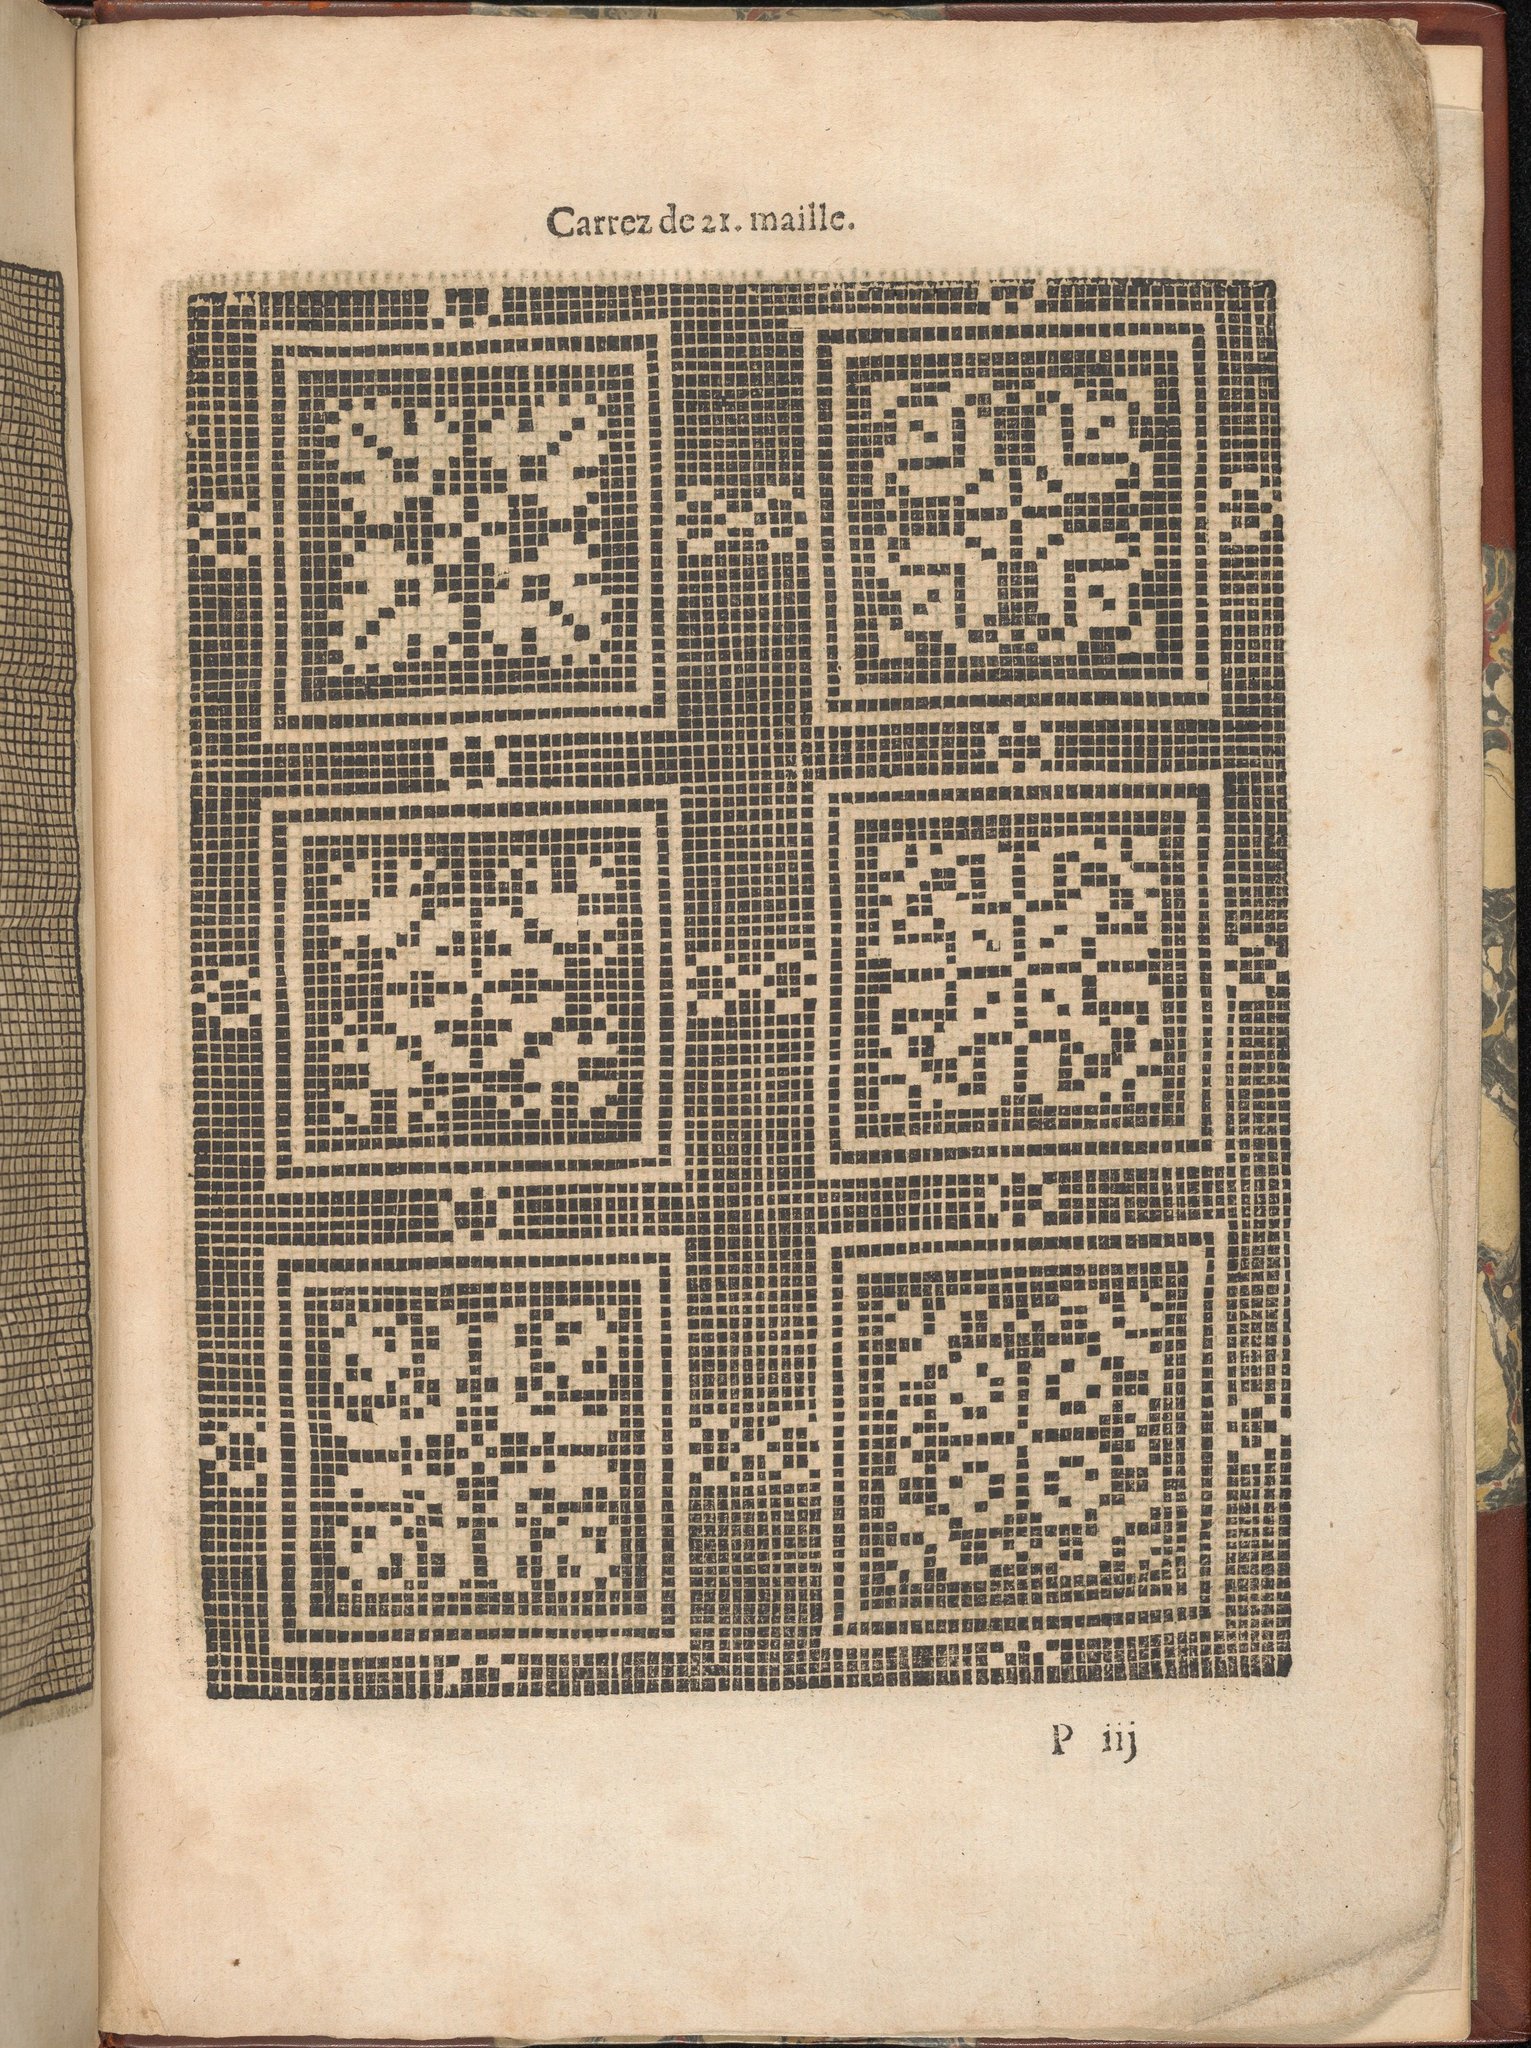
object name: book print ornament architecture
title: Les Secondes Oeuvres, et Subtiles Inventions De Lingerie du Seigneur Federic de Vinciolo Venitien, page 59 (recto)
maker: federico de vinciolo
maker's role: designer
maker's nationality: italian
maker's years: 1582-1599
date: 1603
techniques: woodcut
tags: ornament